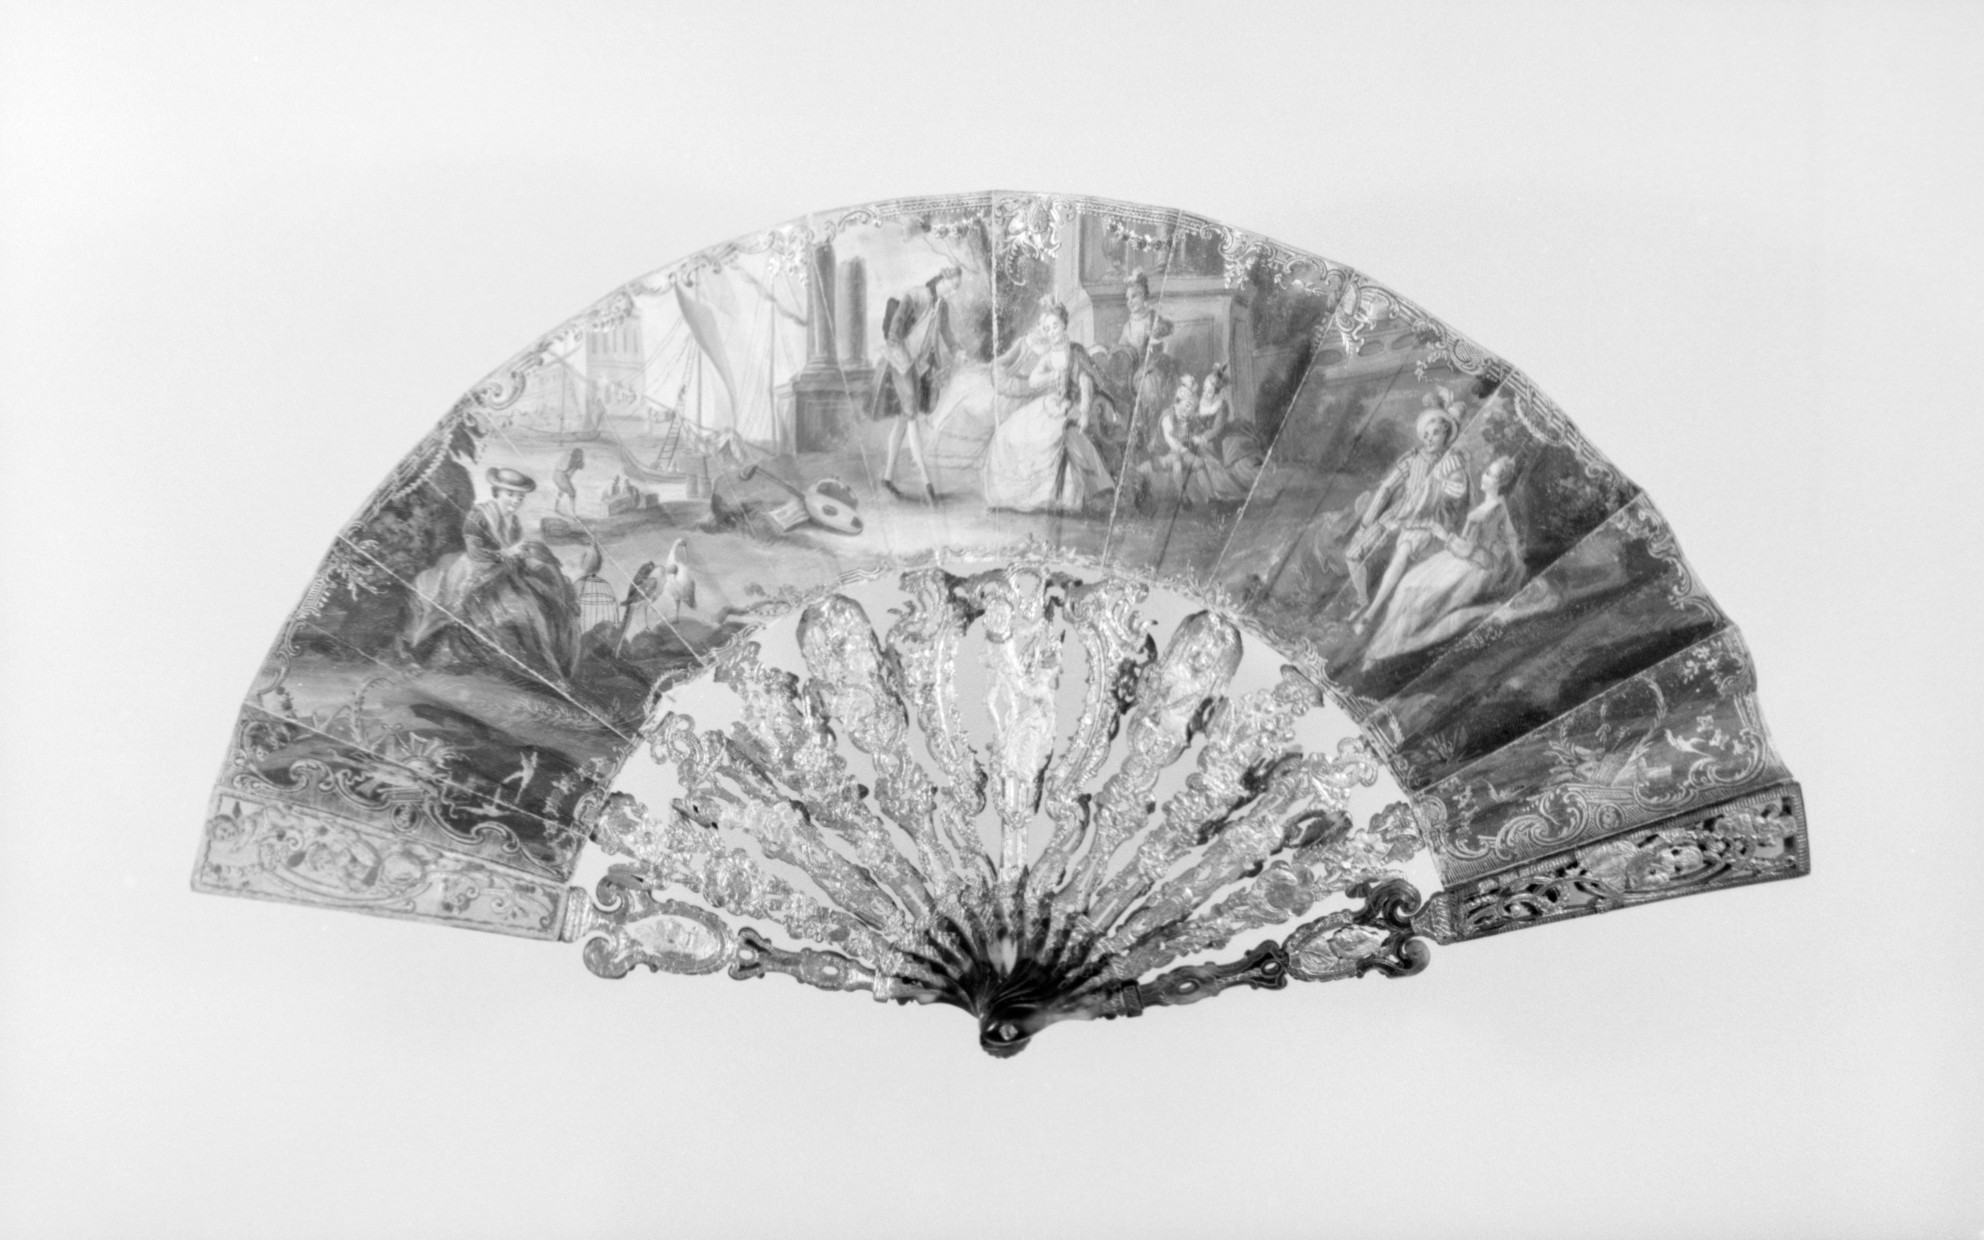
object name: fan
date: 1701-1800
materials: paper, shell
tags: birds,men,women